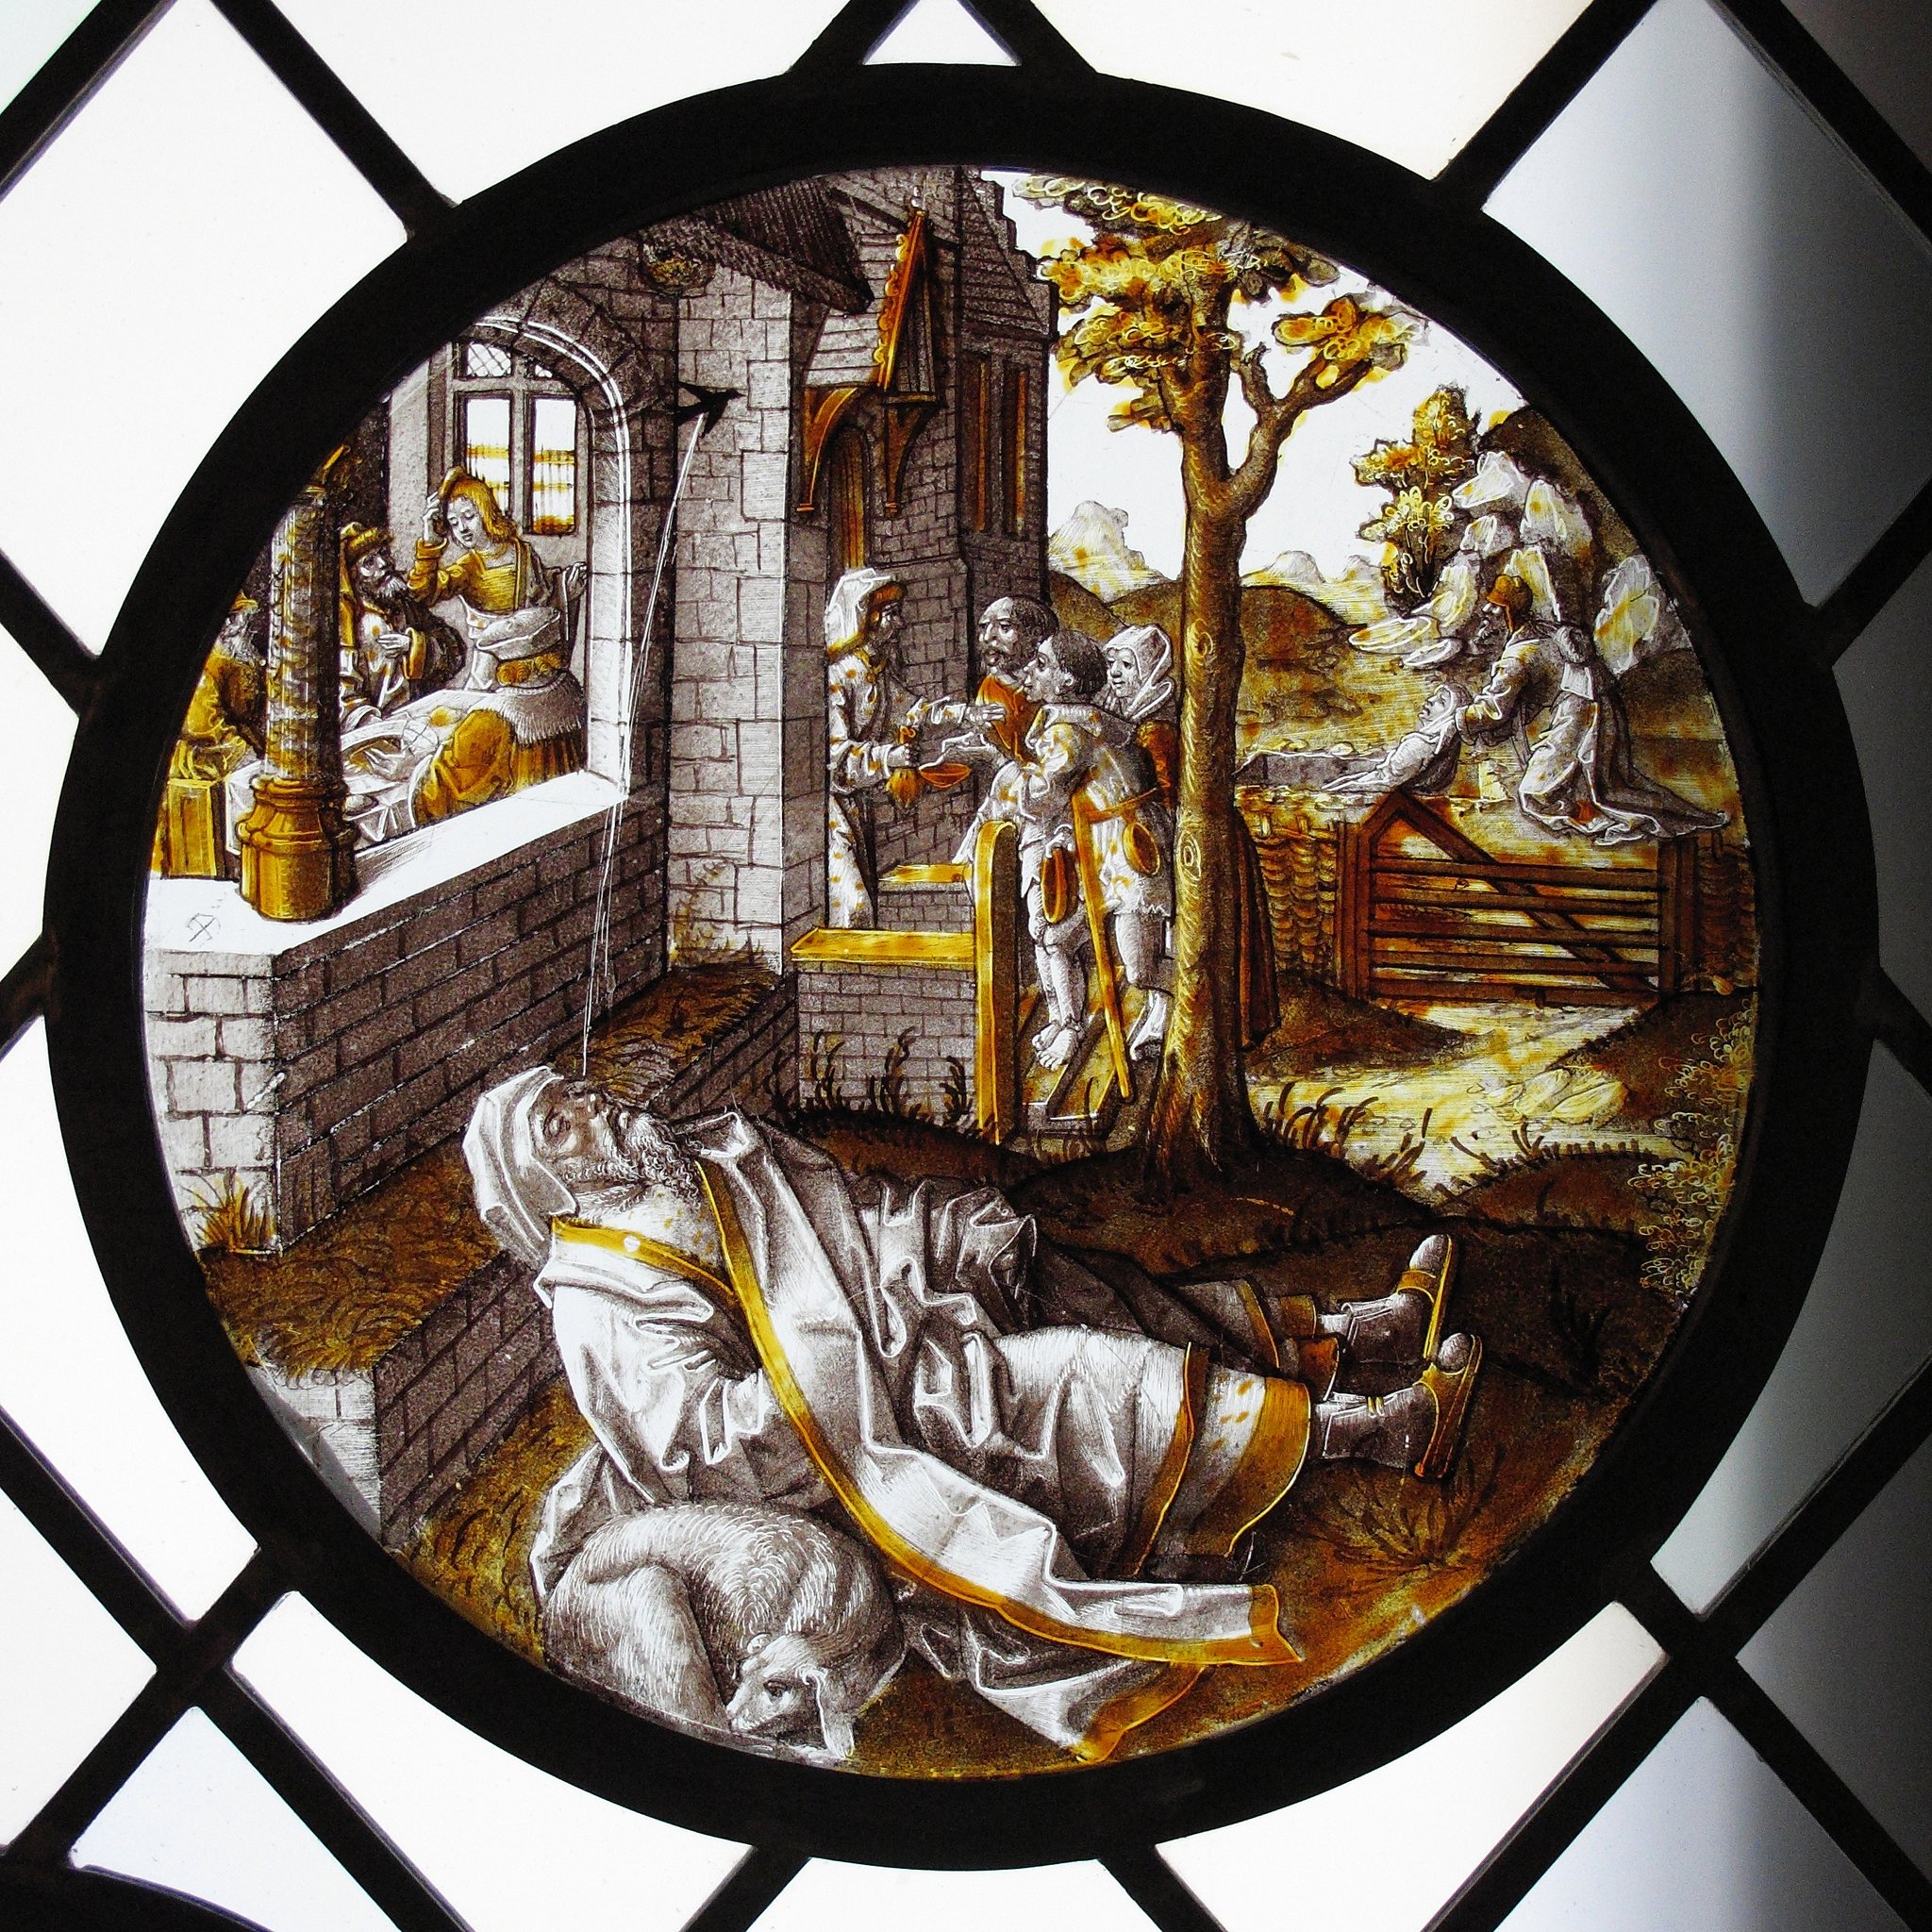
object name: roundel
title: Roundel with the Blinding of Tobit (from a Series)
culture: south netherlandish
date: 1510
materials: glass, paint, pigment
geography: south netherlands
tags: men,women,dogs